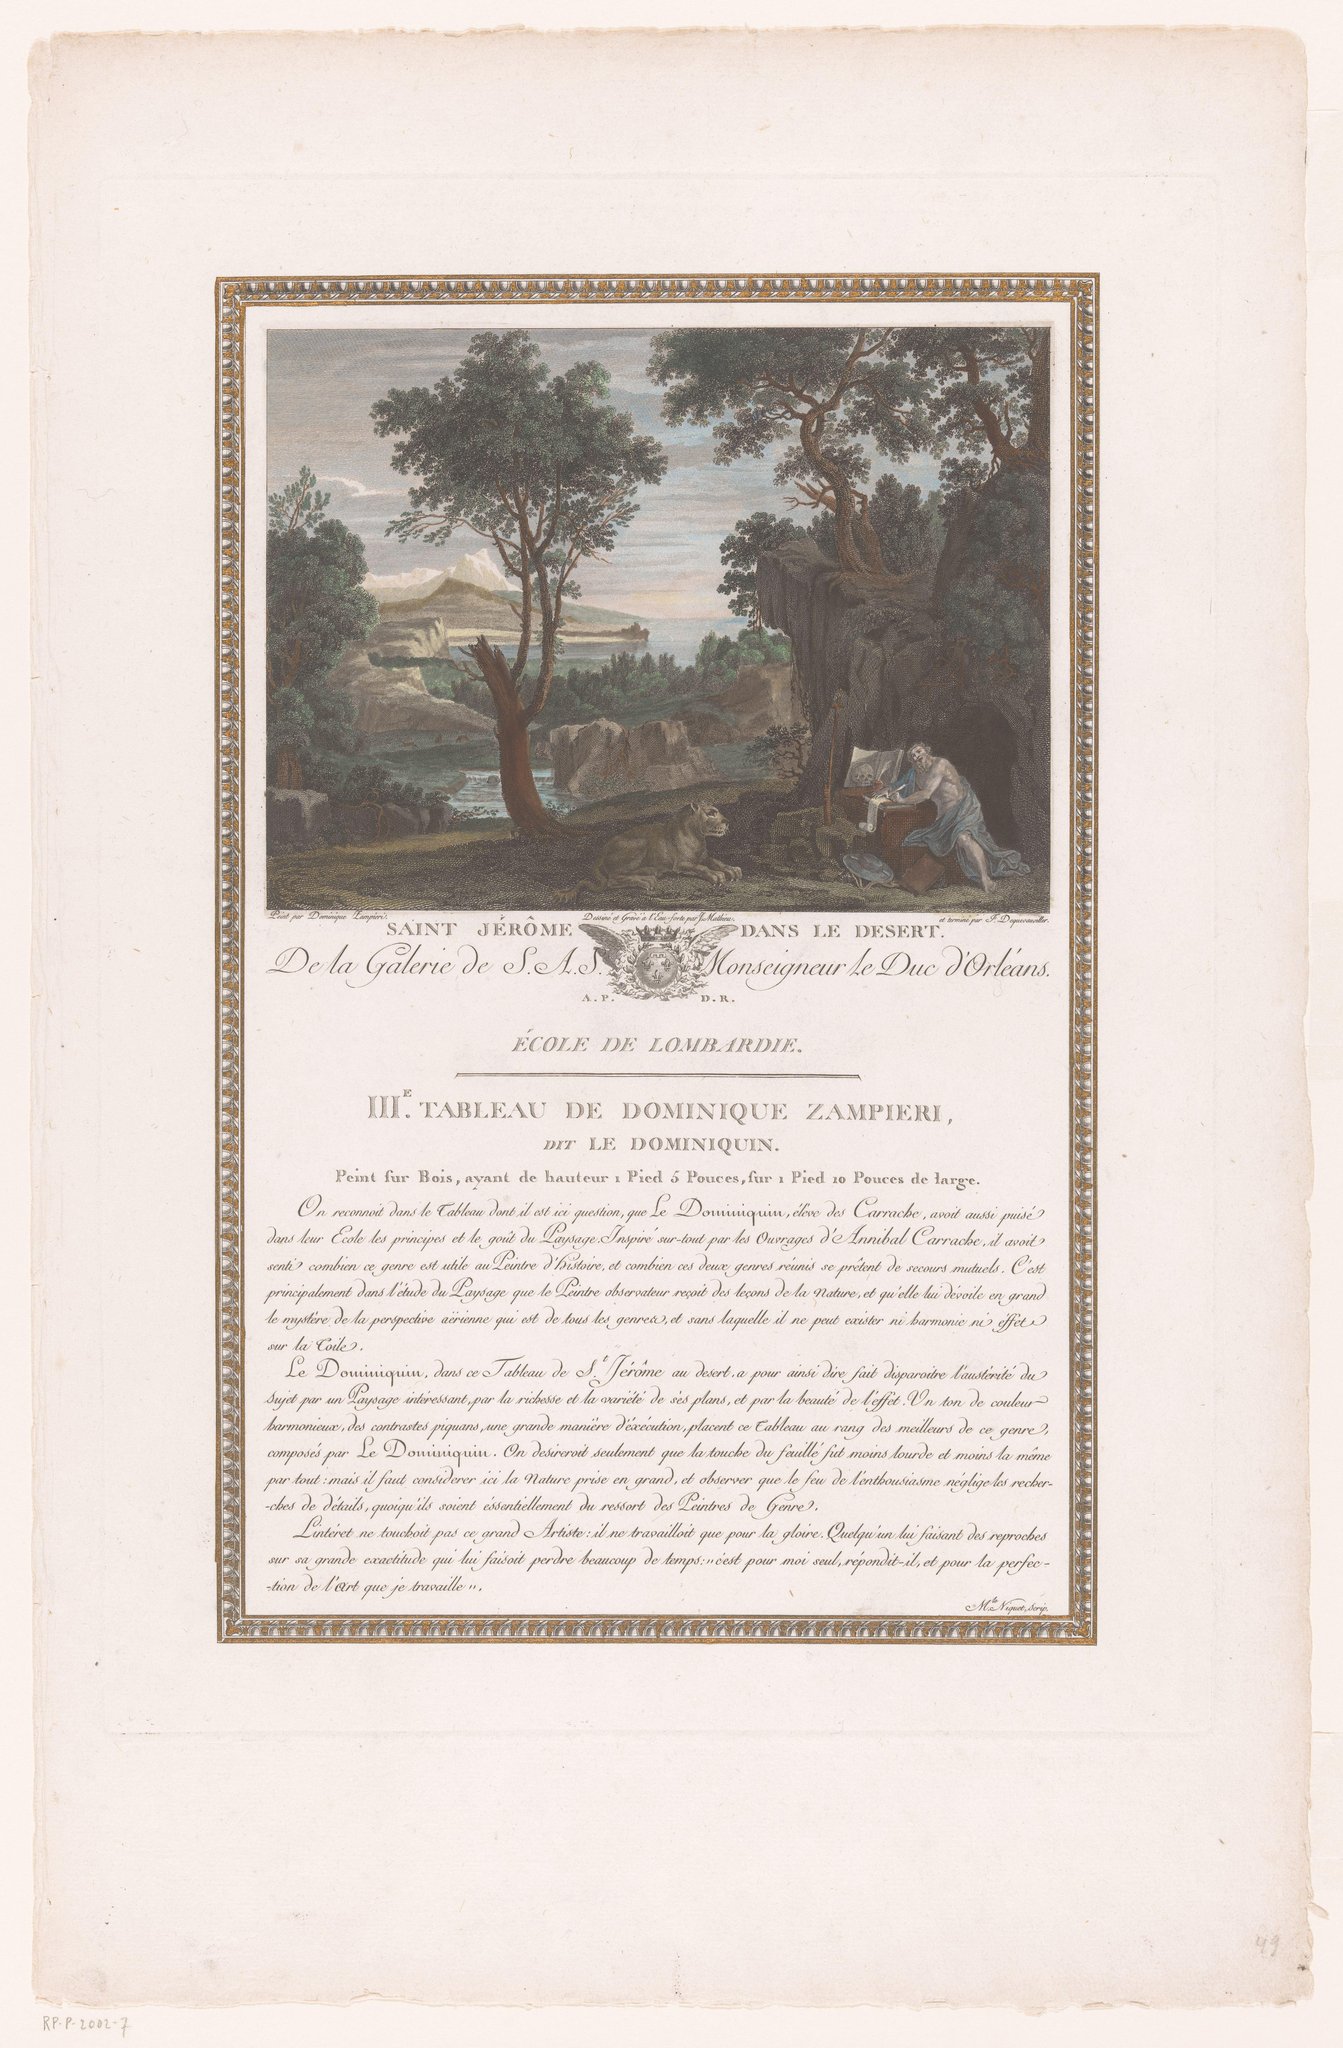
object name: print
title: La Galerie du Palais Royal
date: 1786-1808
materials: paper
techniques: engraving, etching, hand coloring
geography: france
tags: st. jerome as penitent in the desert, half naked, kneeling before a crucifix and holding a stone in his hand to beat his breast; a skull (and other 'vanitas' symbols), sometimes a scorpion and a snake beside him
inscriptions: collector's mark: Lugt 2228, collector's mark: Lugt 2760